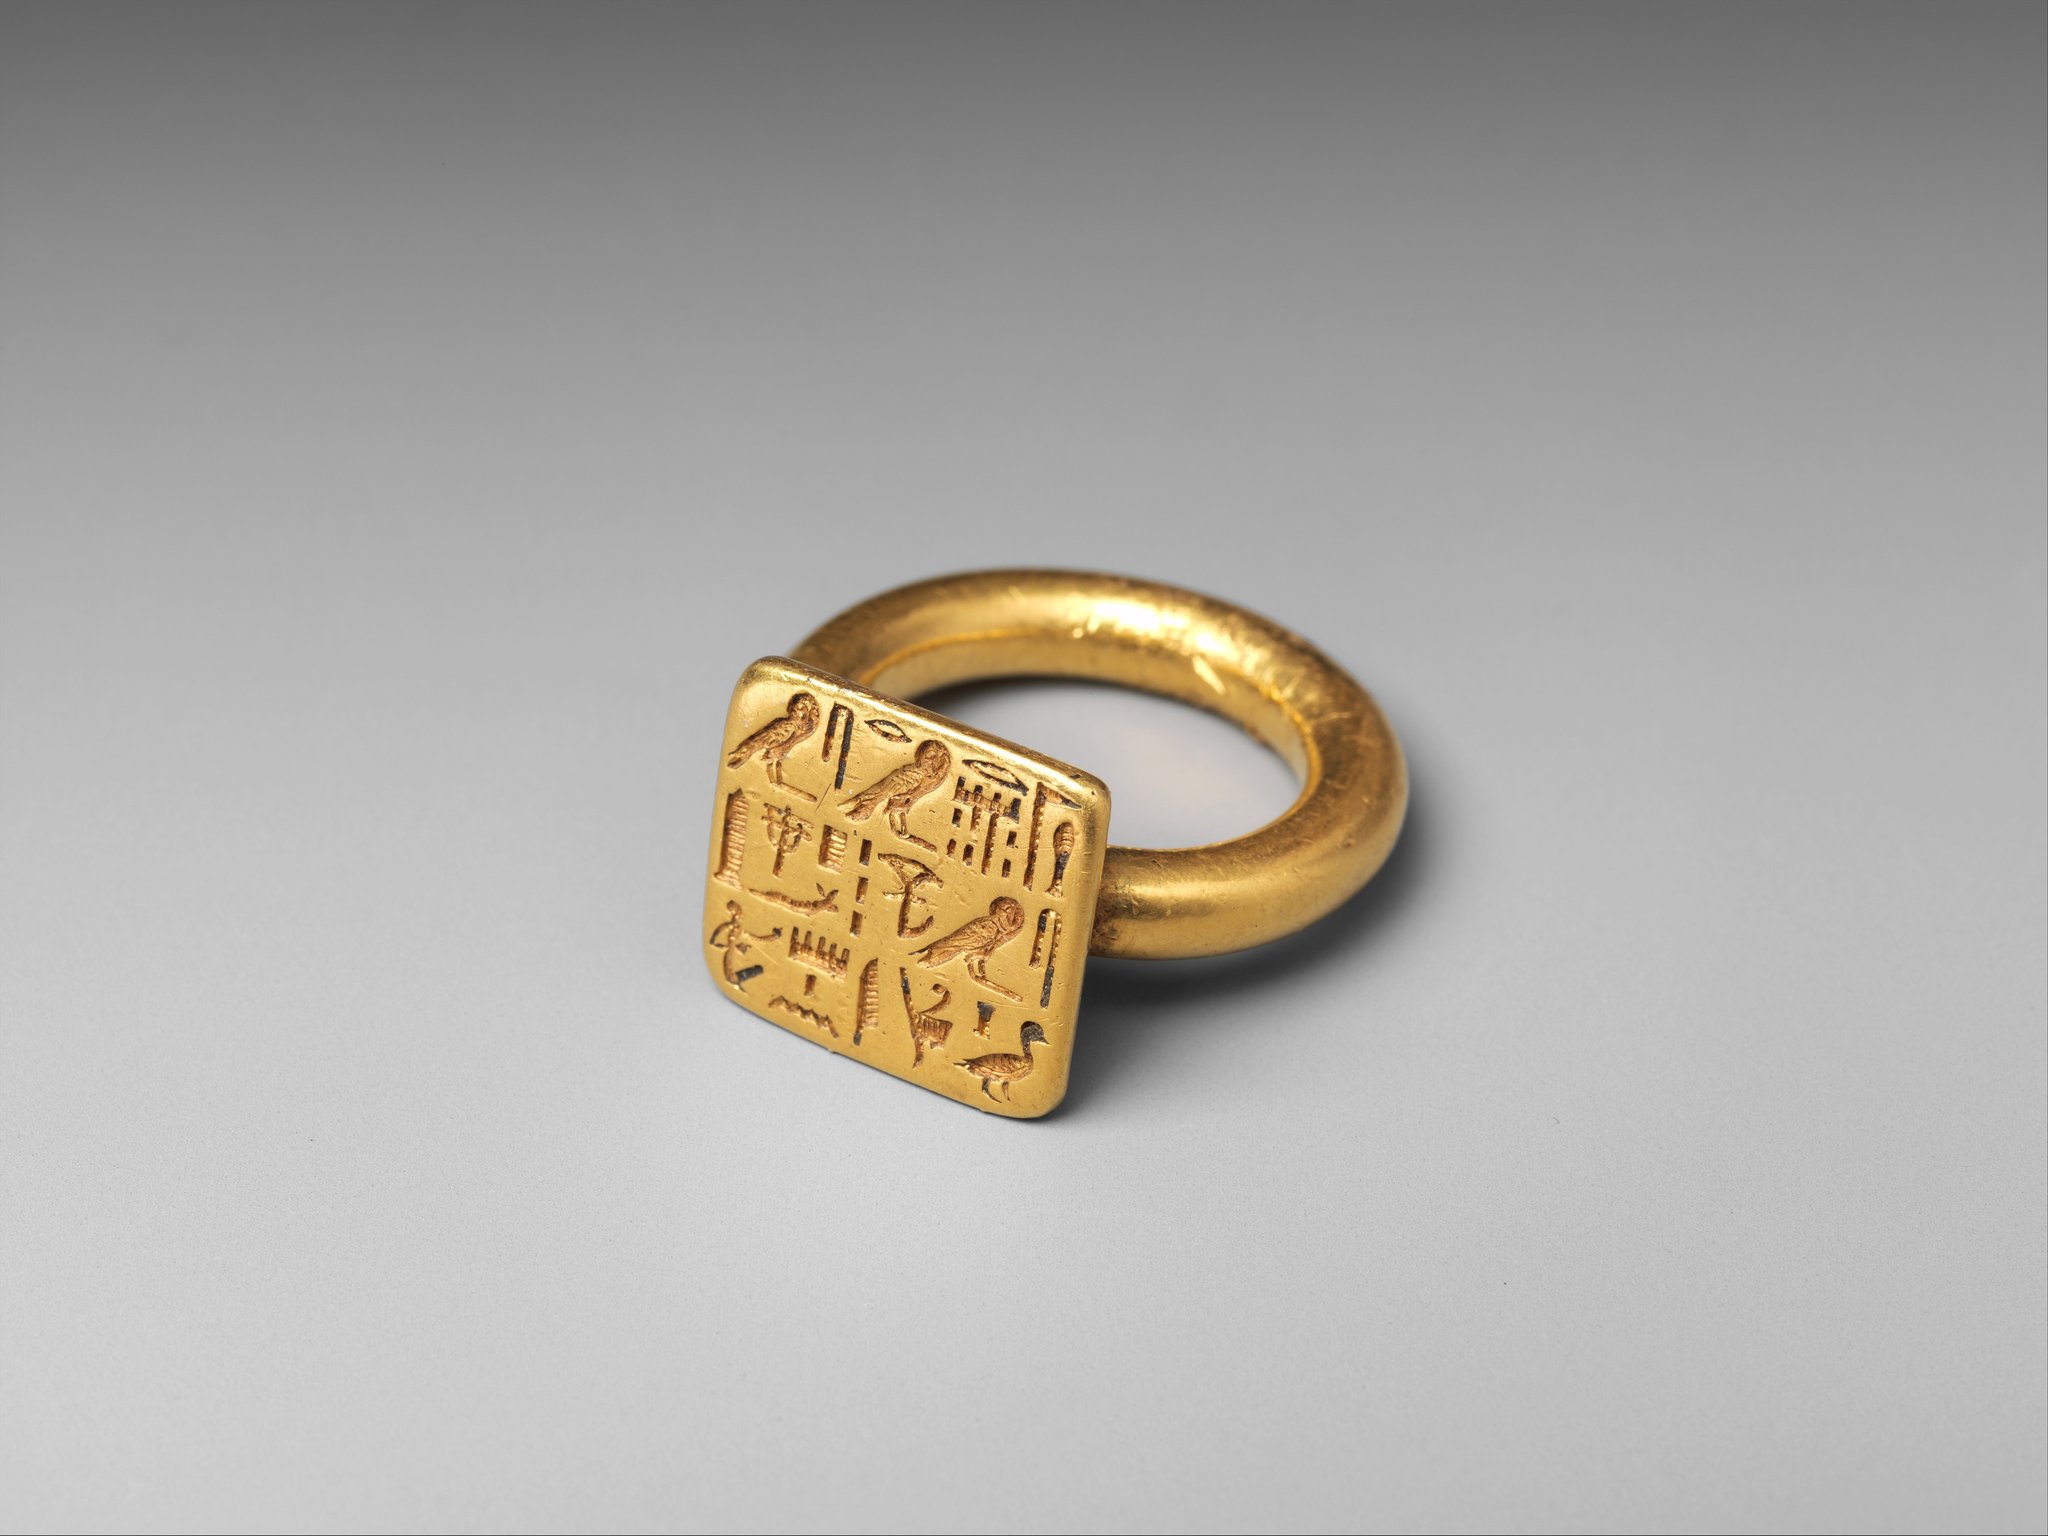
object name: ring, sienamun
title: Ring of Priest Sienamun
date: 664-525 BCE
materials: gold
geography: egypt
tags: hieroglyphs